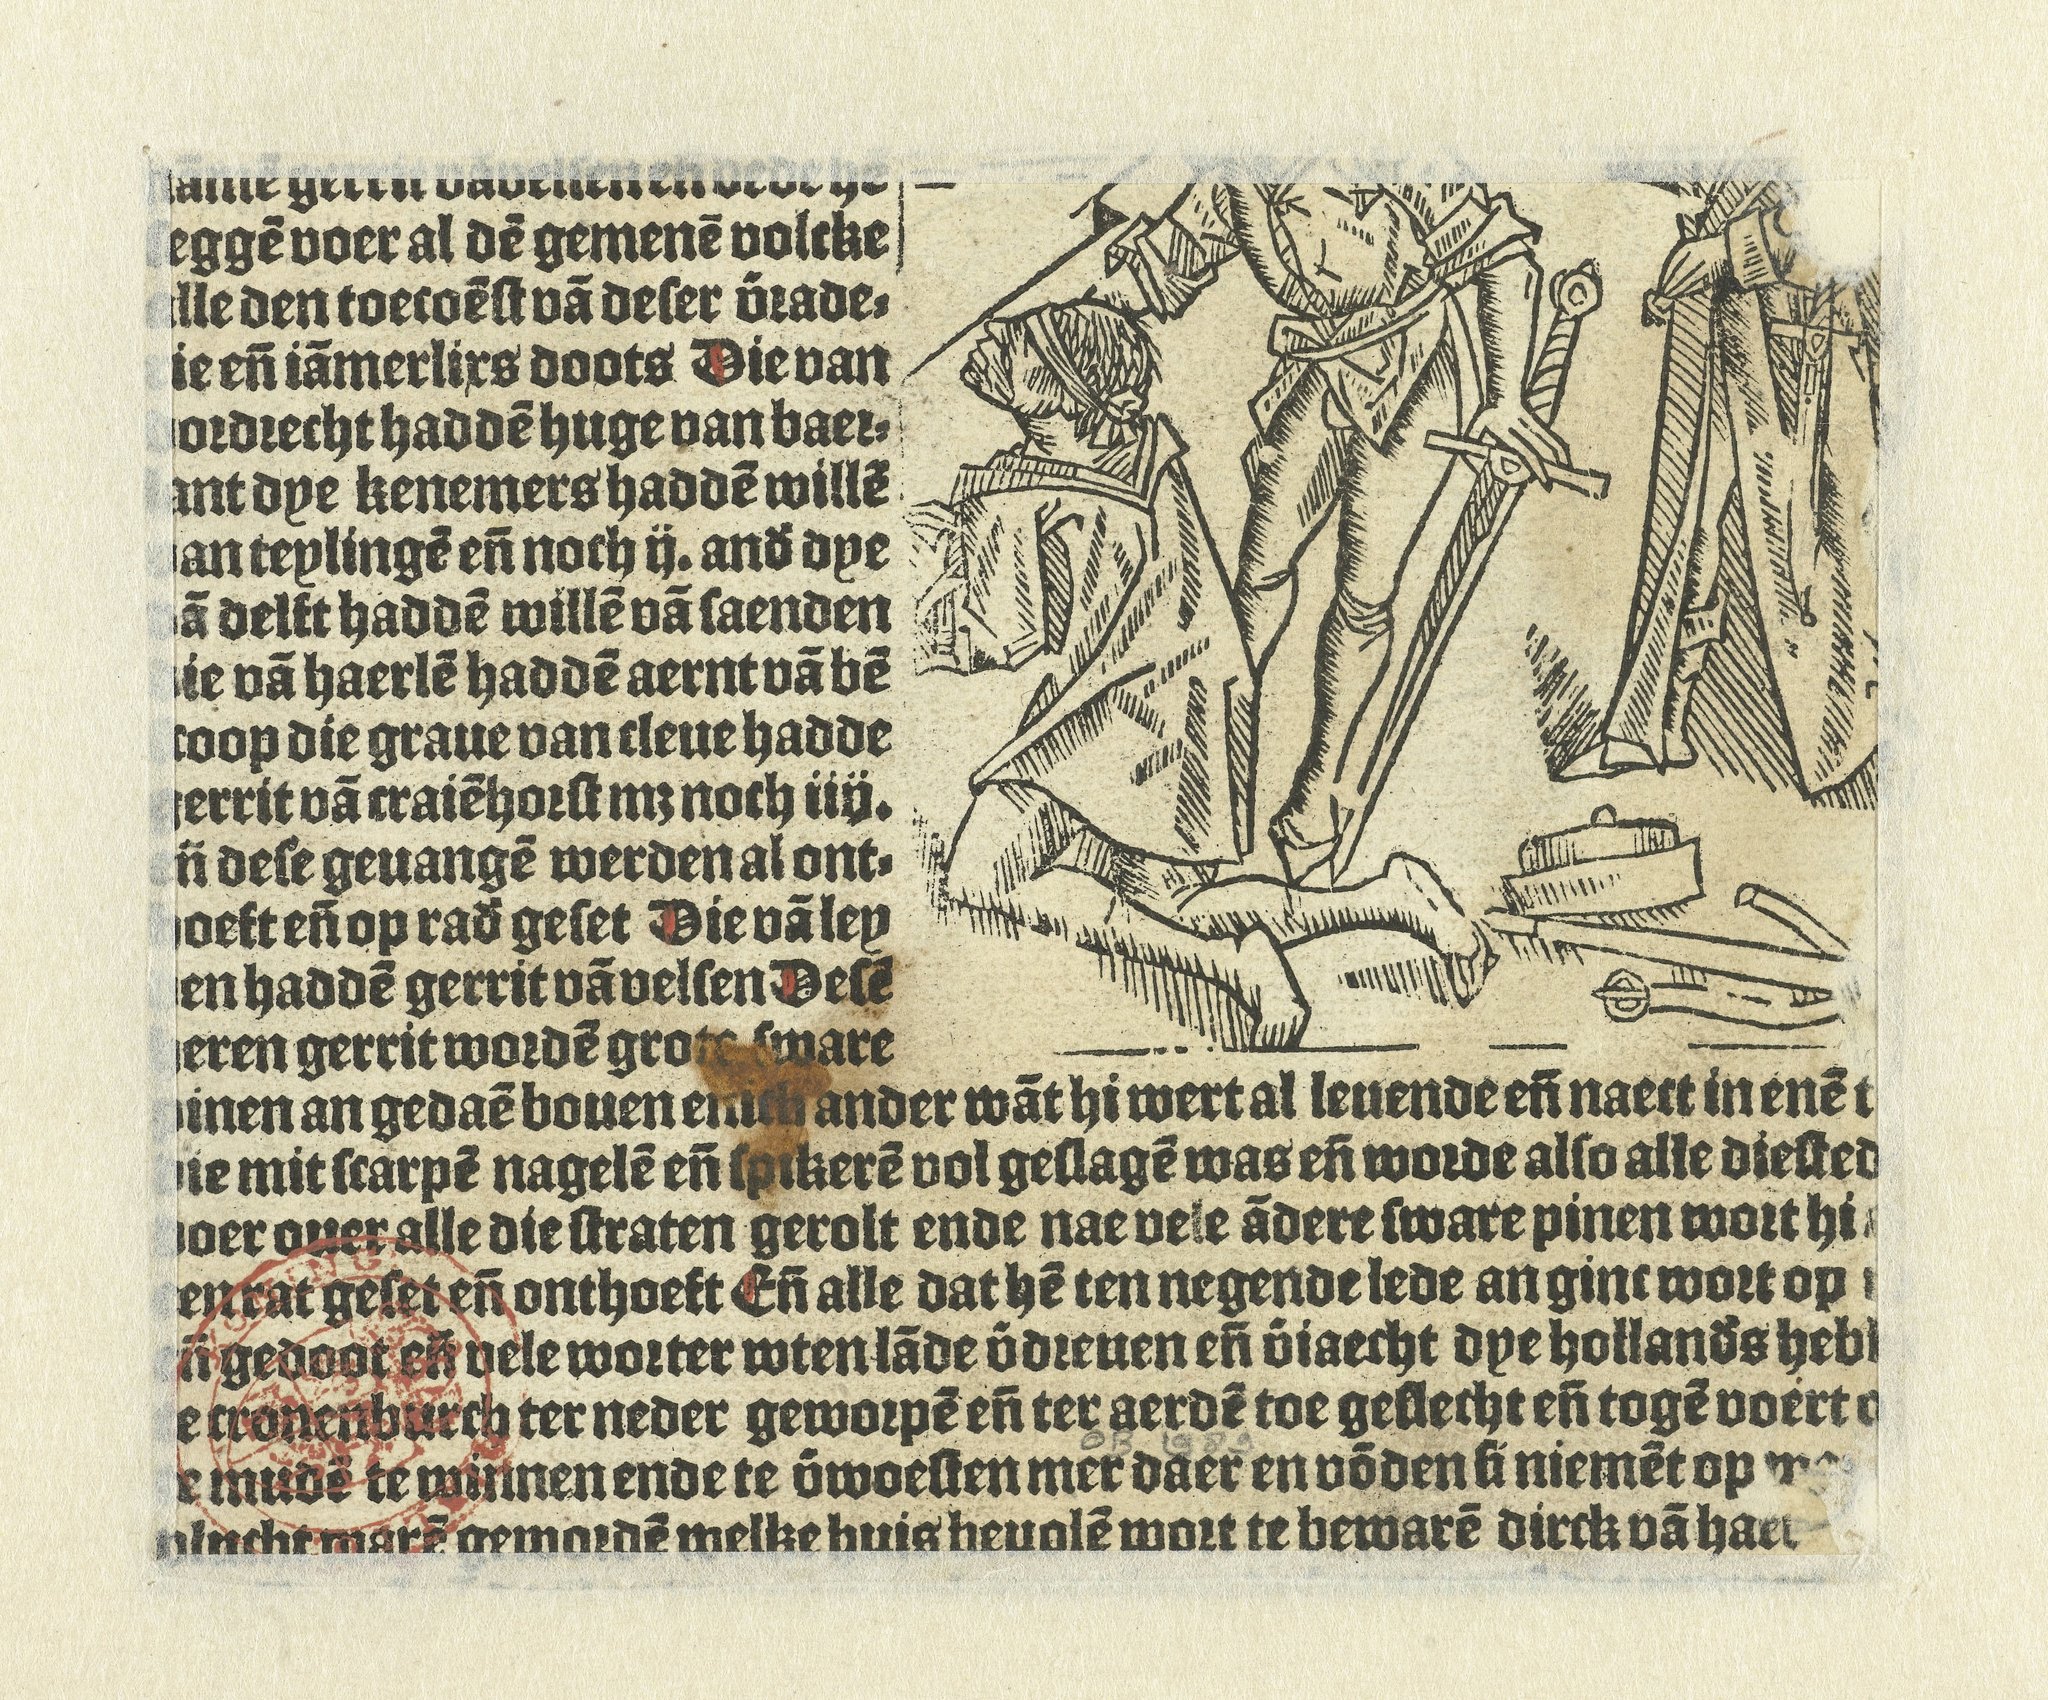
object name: book illustration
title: De onthoofding van Gerard van Velsen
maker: Anonymous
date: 1517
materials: paper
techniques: woodcut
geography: low countries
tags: violent death by beheading, historical events and situations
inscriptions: collector's mark: Lugt 240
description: Late afdruk van de versneden houtblokken van Le Chevalier déliberé (Gouda 1486). Eén blad van veertien uit Cronycke van Hollandt, uitgegeven door Jan Seversz, te Leiden in 1517 en 1530.